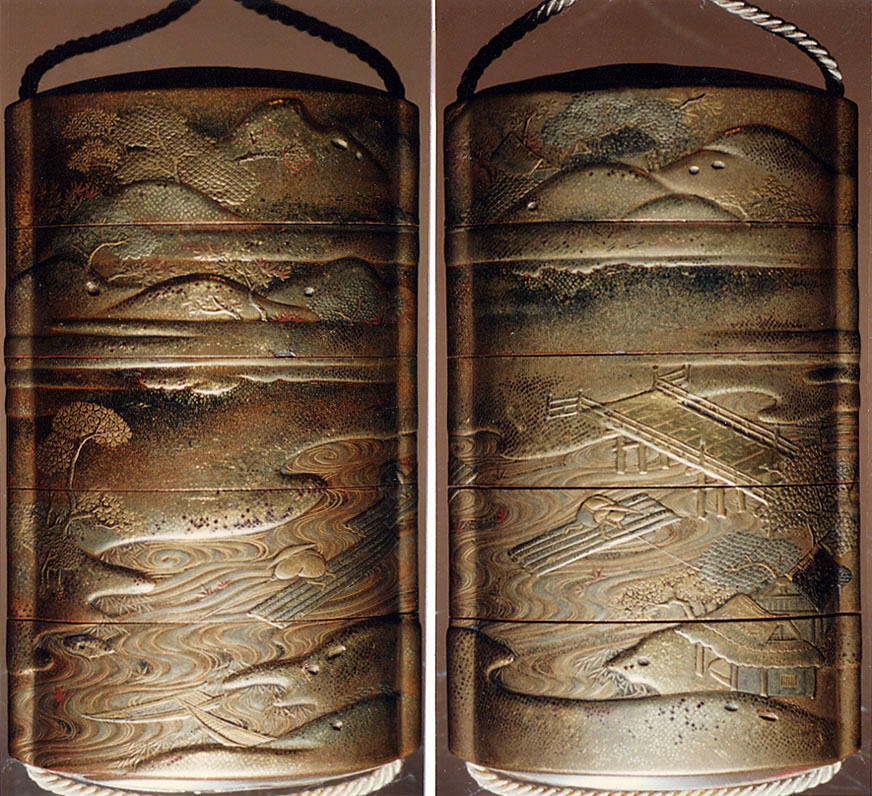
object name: inrō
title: Case (Inrō) with Design of Persons Steering Wood Rafts on River in Mountain Landscape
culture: japanese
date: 1801-1900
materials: gold, lacquer, silver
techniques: fundame, hiramakie, maki-e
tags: human figures,bridges,rivers,mountains